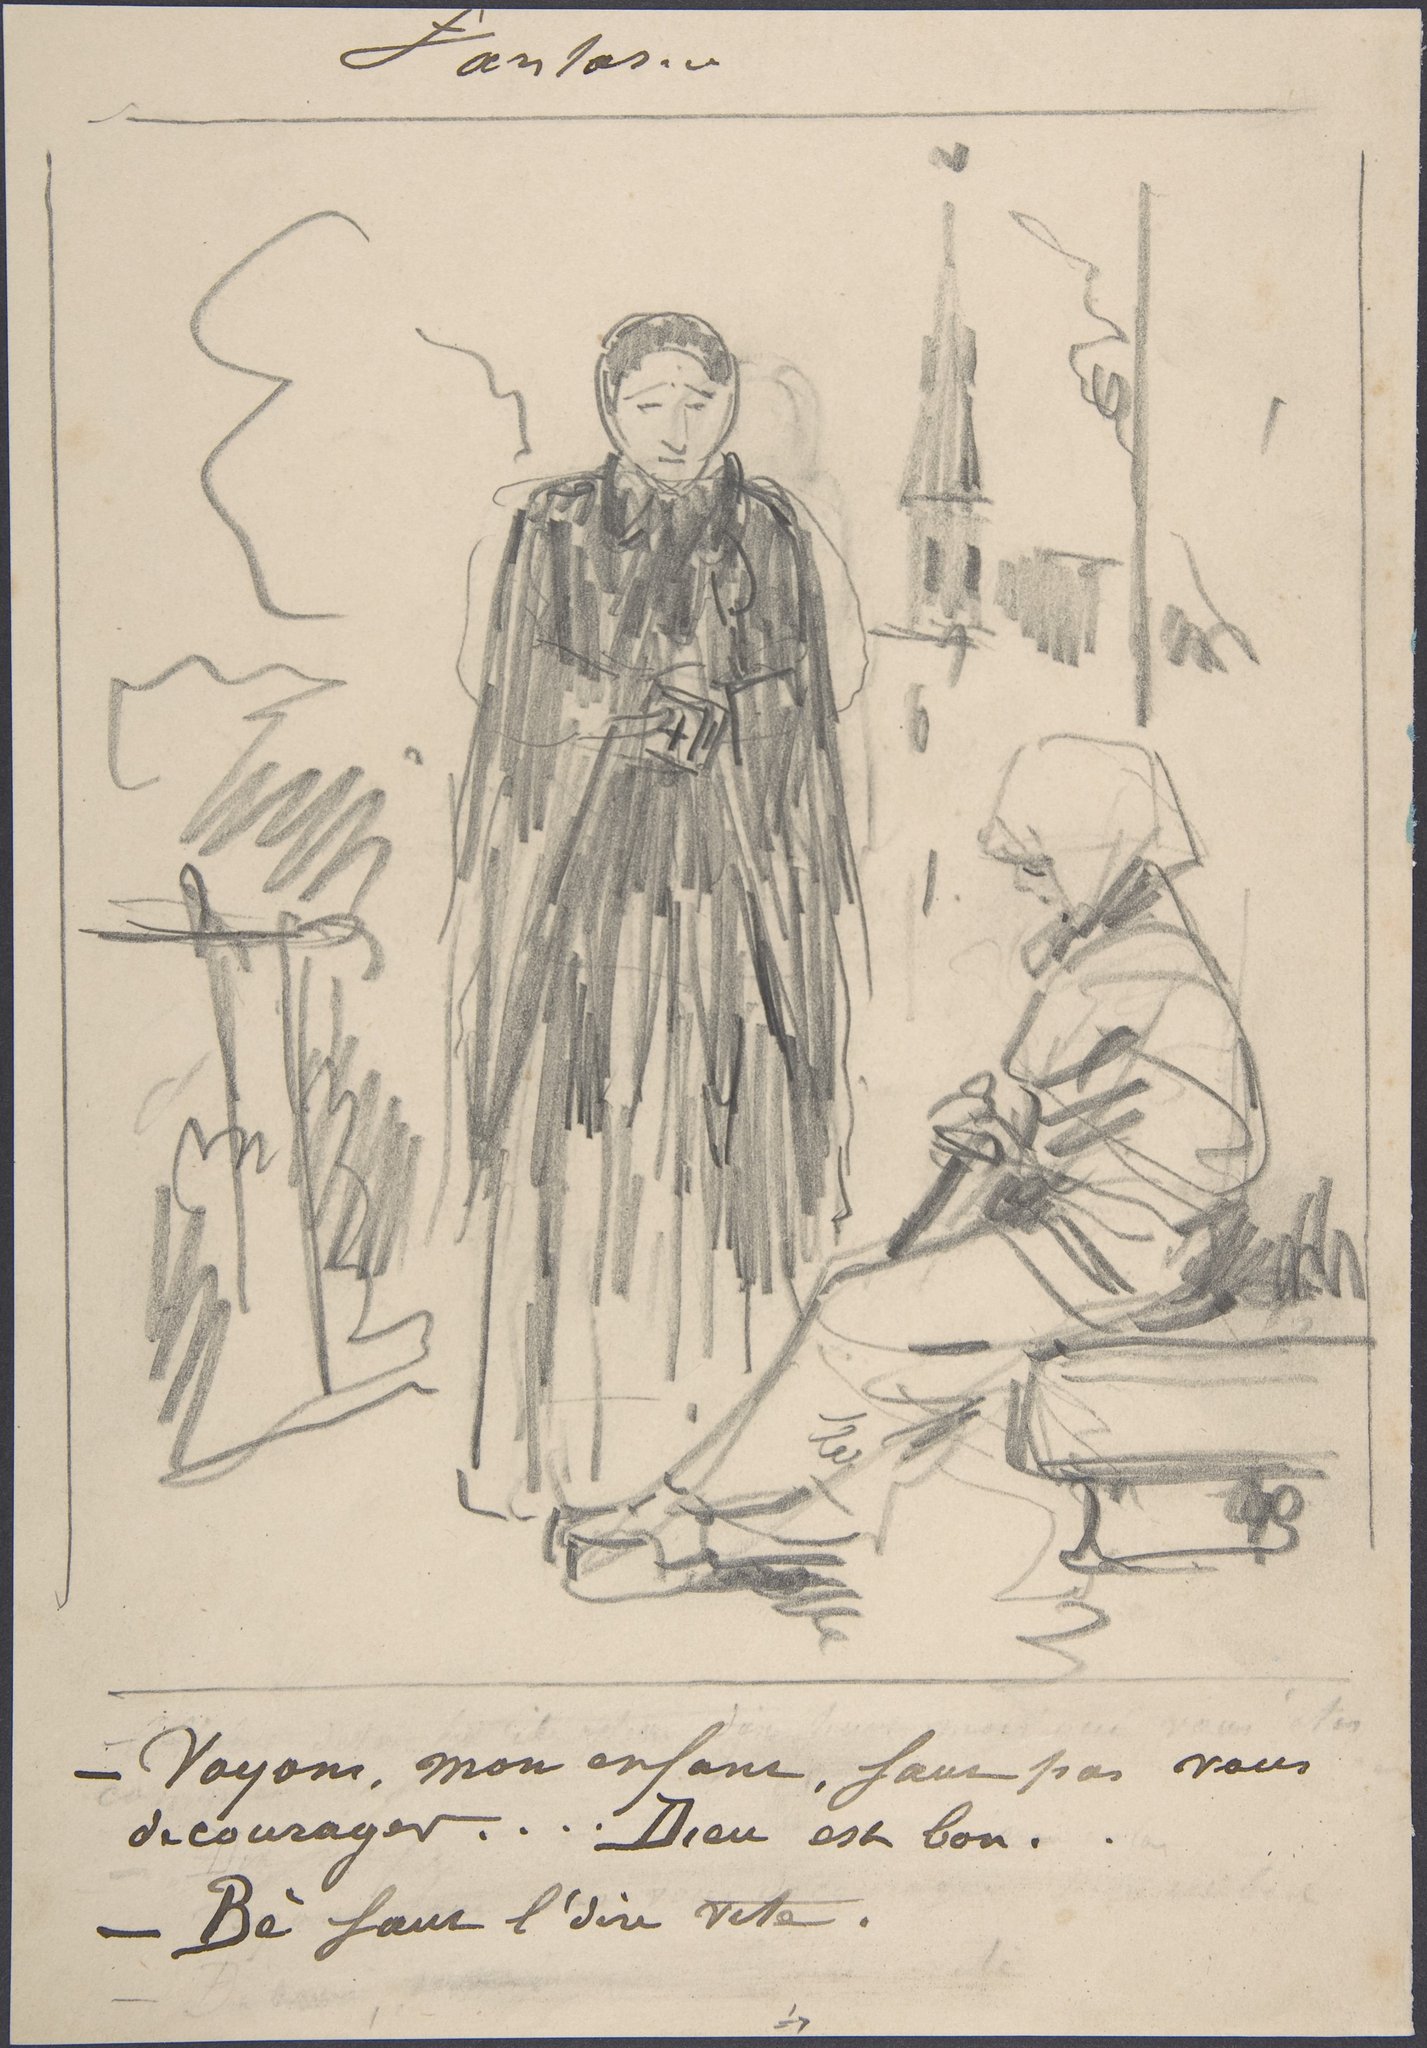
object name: drawing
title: Caricature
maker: anonymous, french, 19th century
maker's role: artist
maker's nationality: french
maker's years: 1800-1900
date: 1801-1900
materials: graphite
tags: human figures